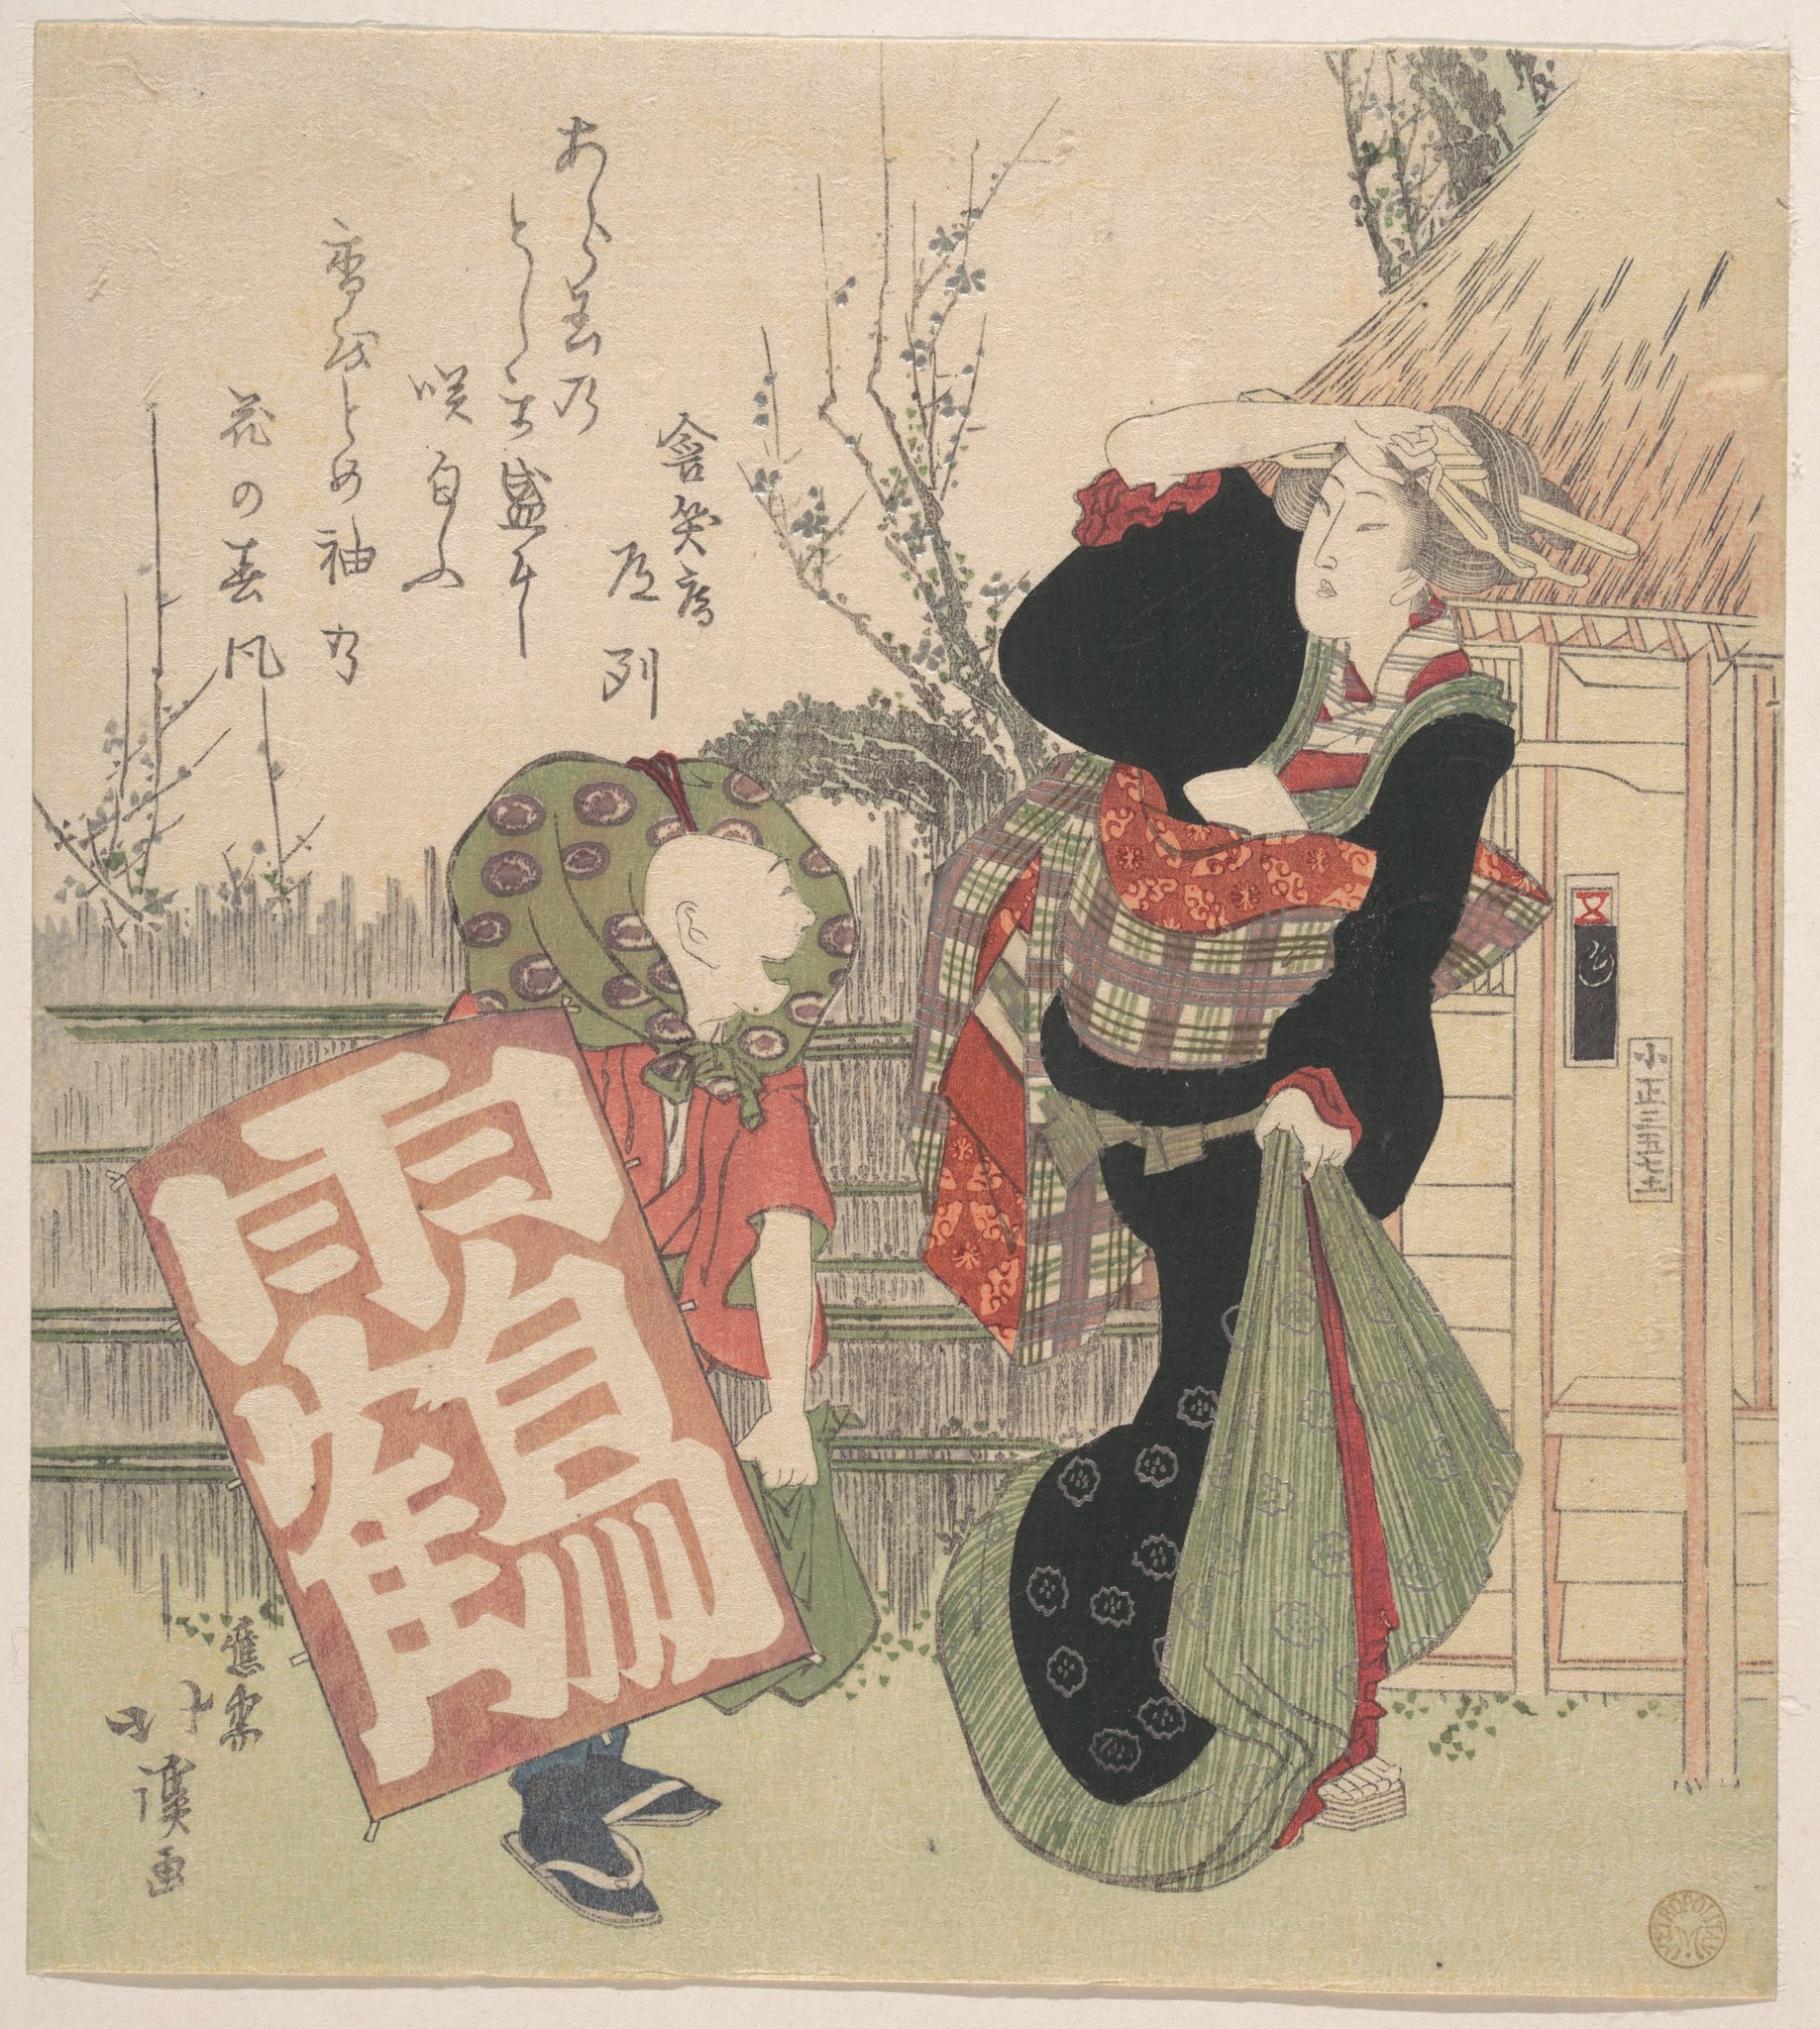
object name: print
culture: japanese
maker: totoya hokkei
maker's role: artist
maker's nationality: japanese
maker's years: 1780-1850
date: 1830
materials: ink, paper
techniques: surimono, woodblock print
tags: boys,women